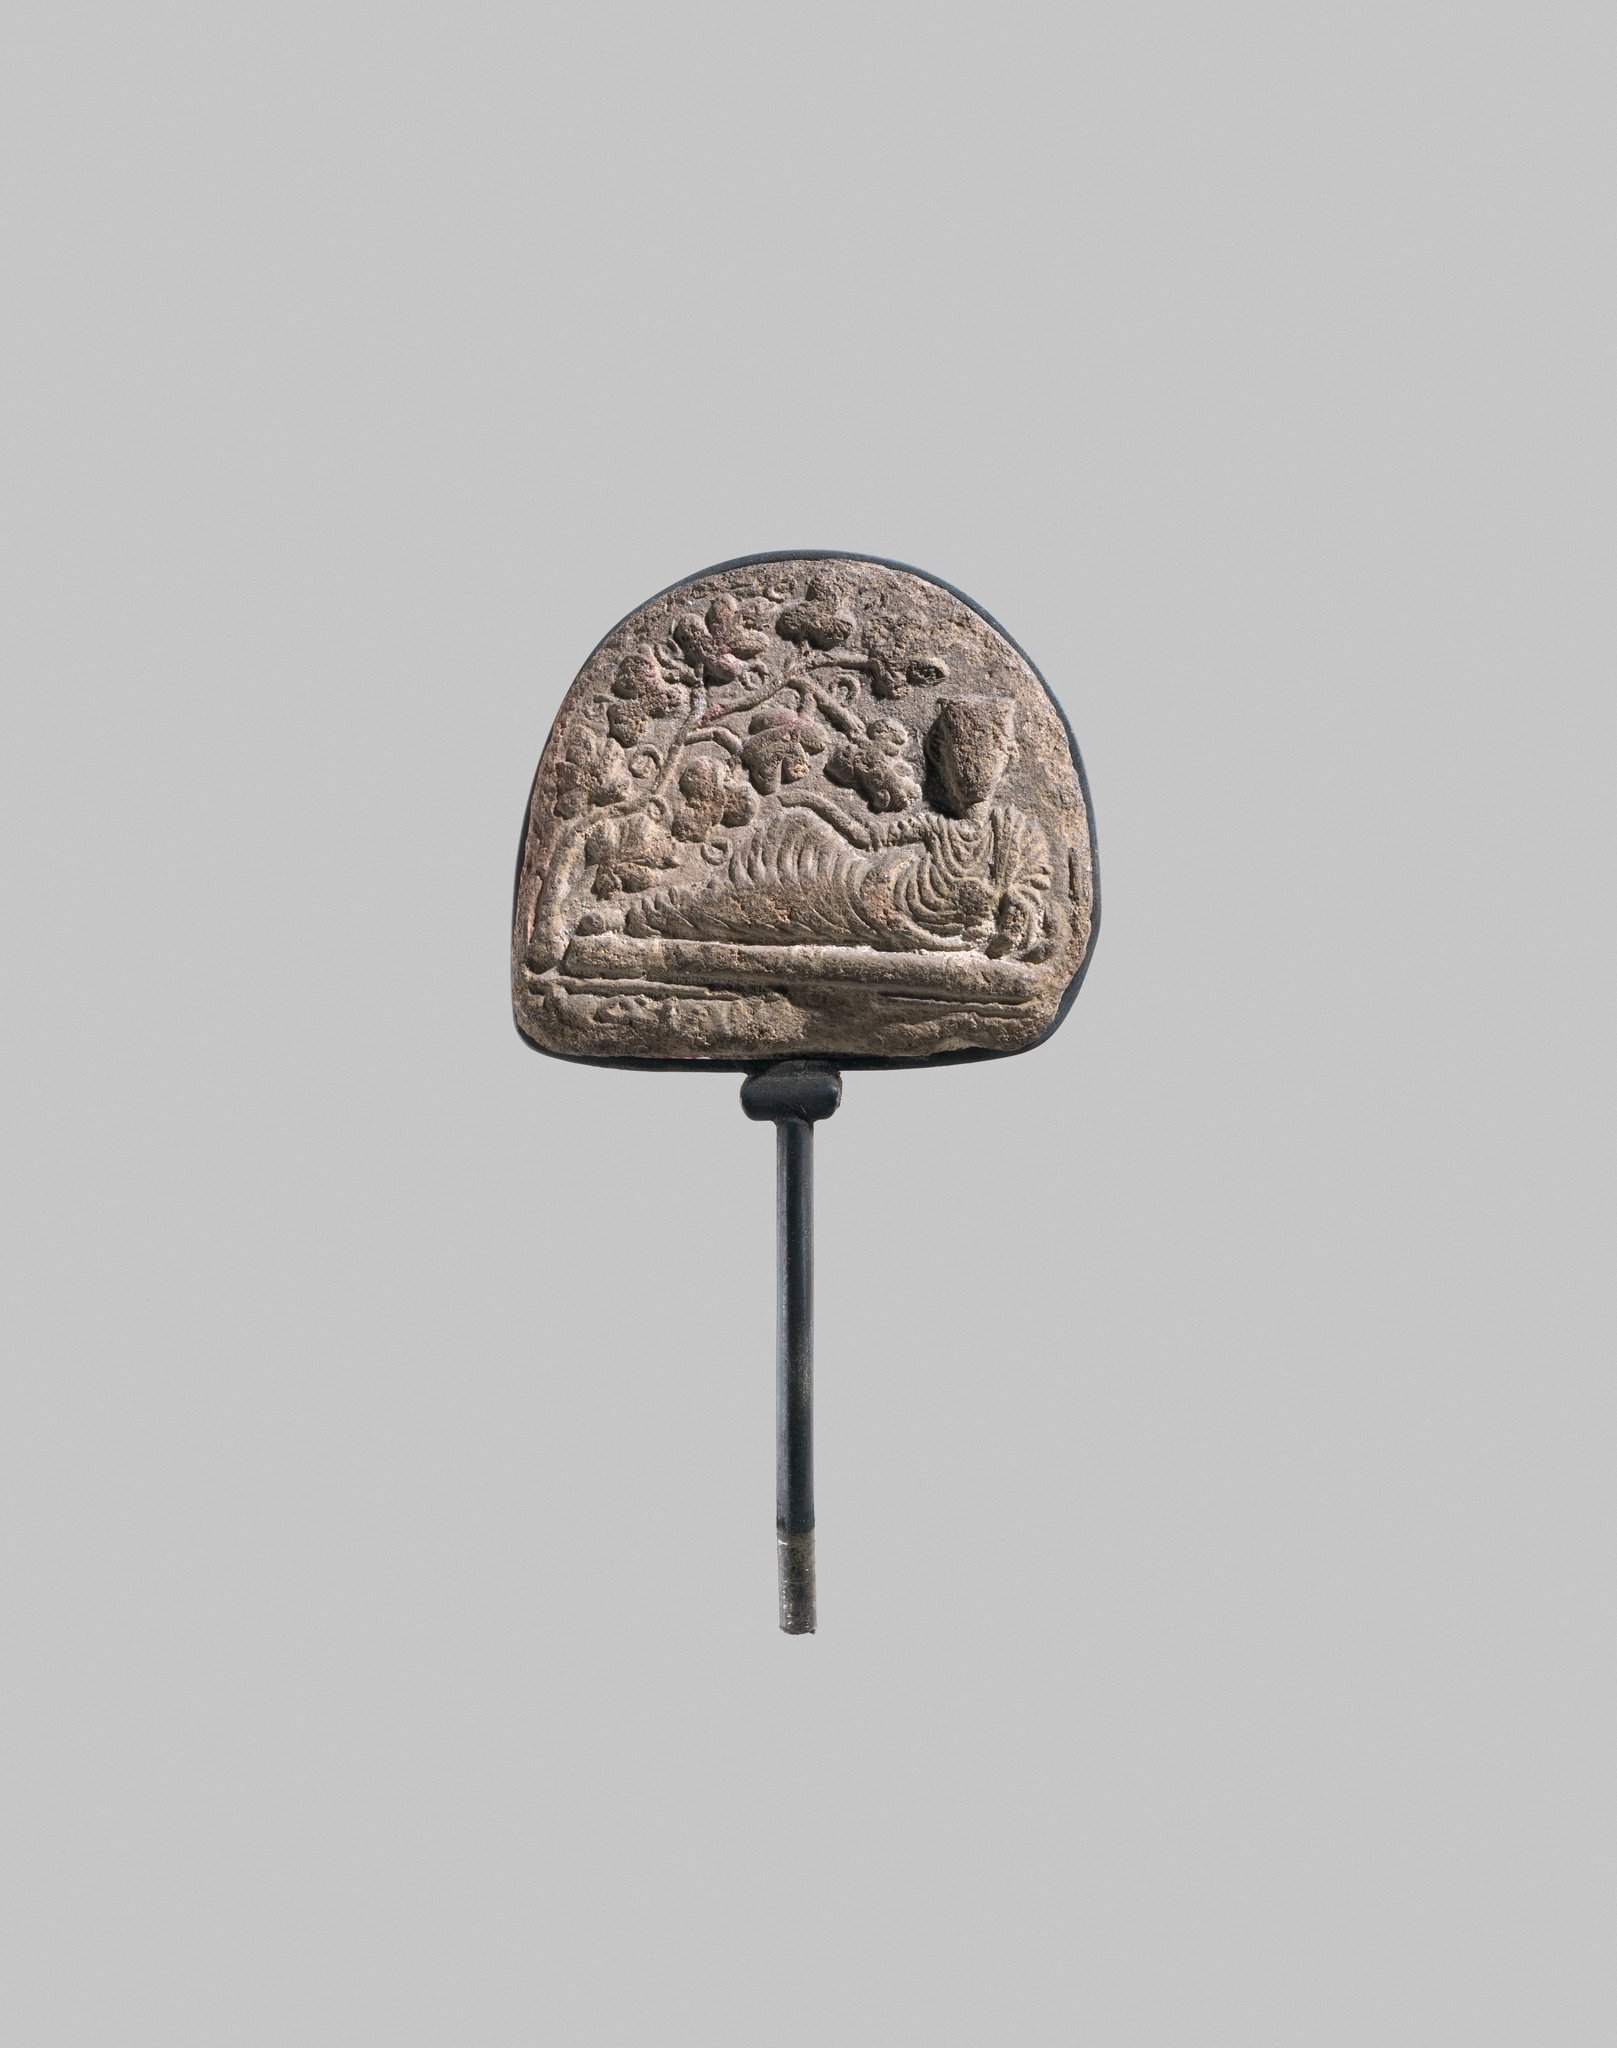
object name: relief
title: Tessera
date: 1-200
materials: ceramic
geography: syria